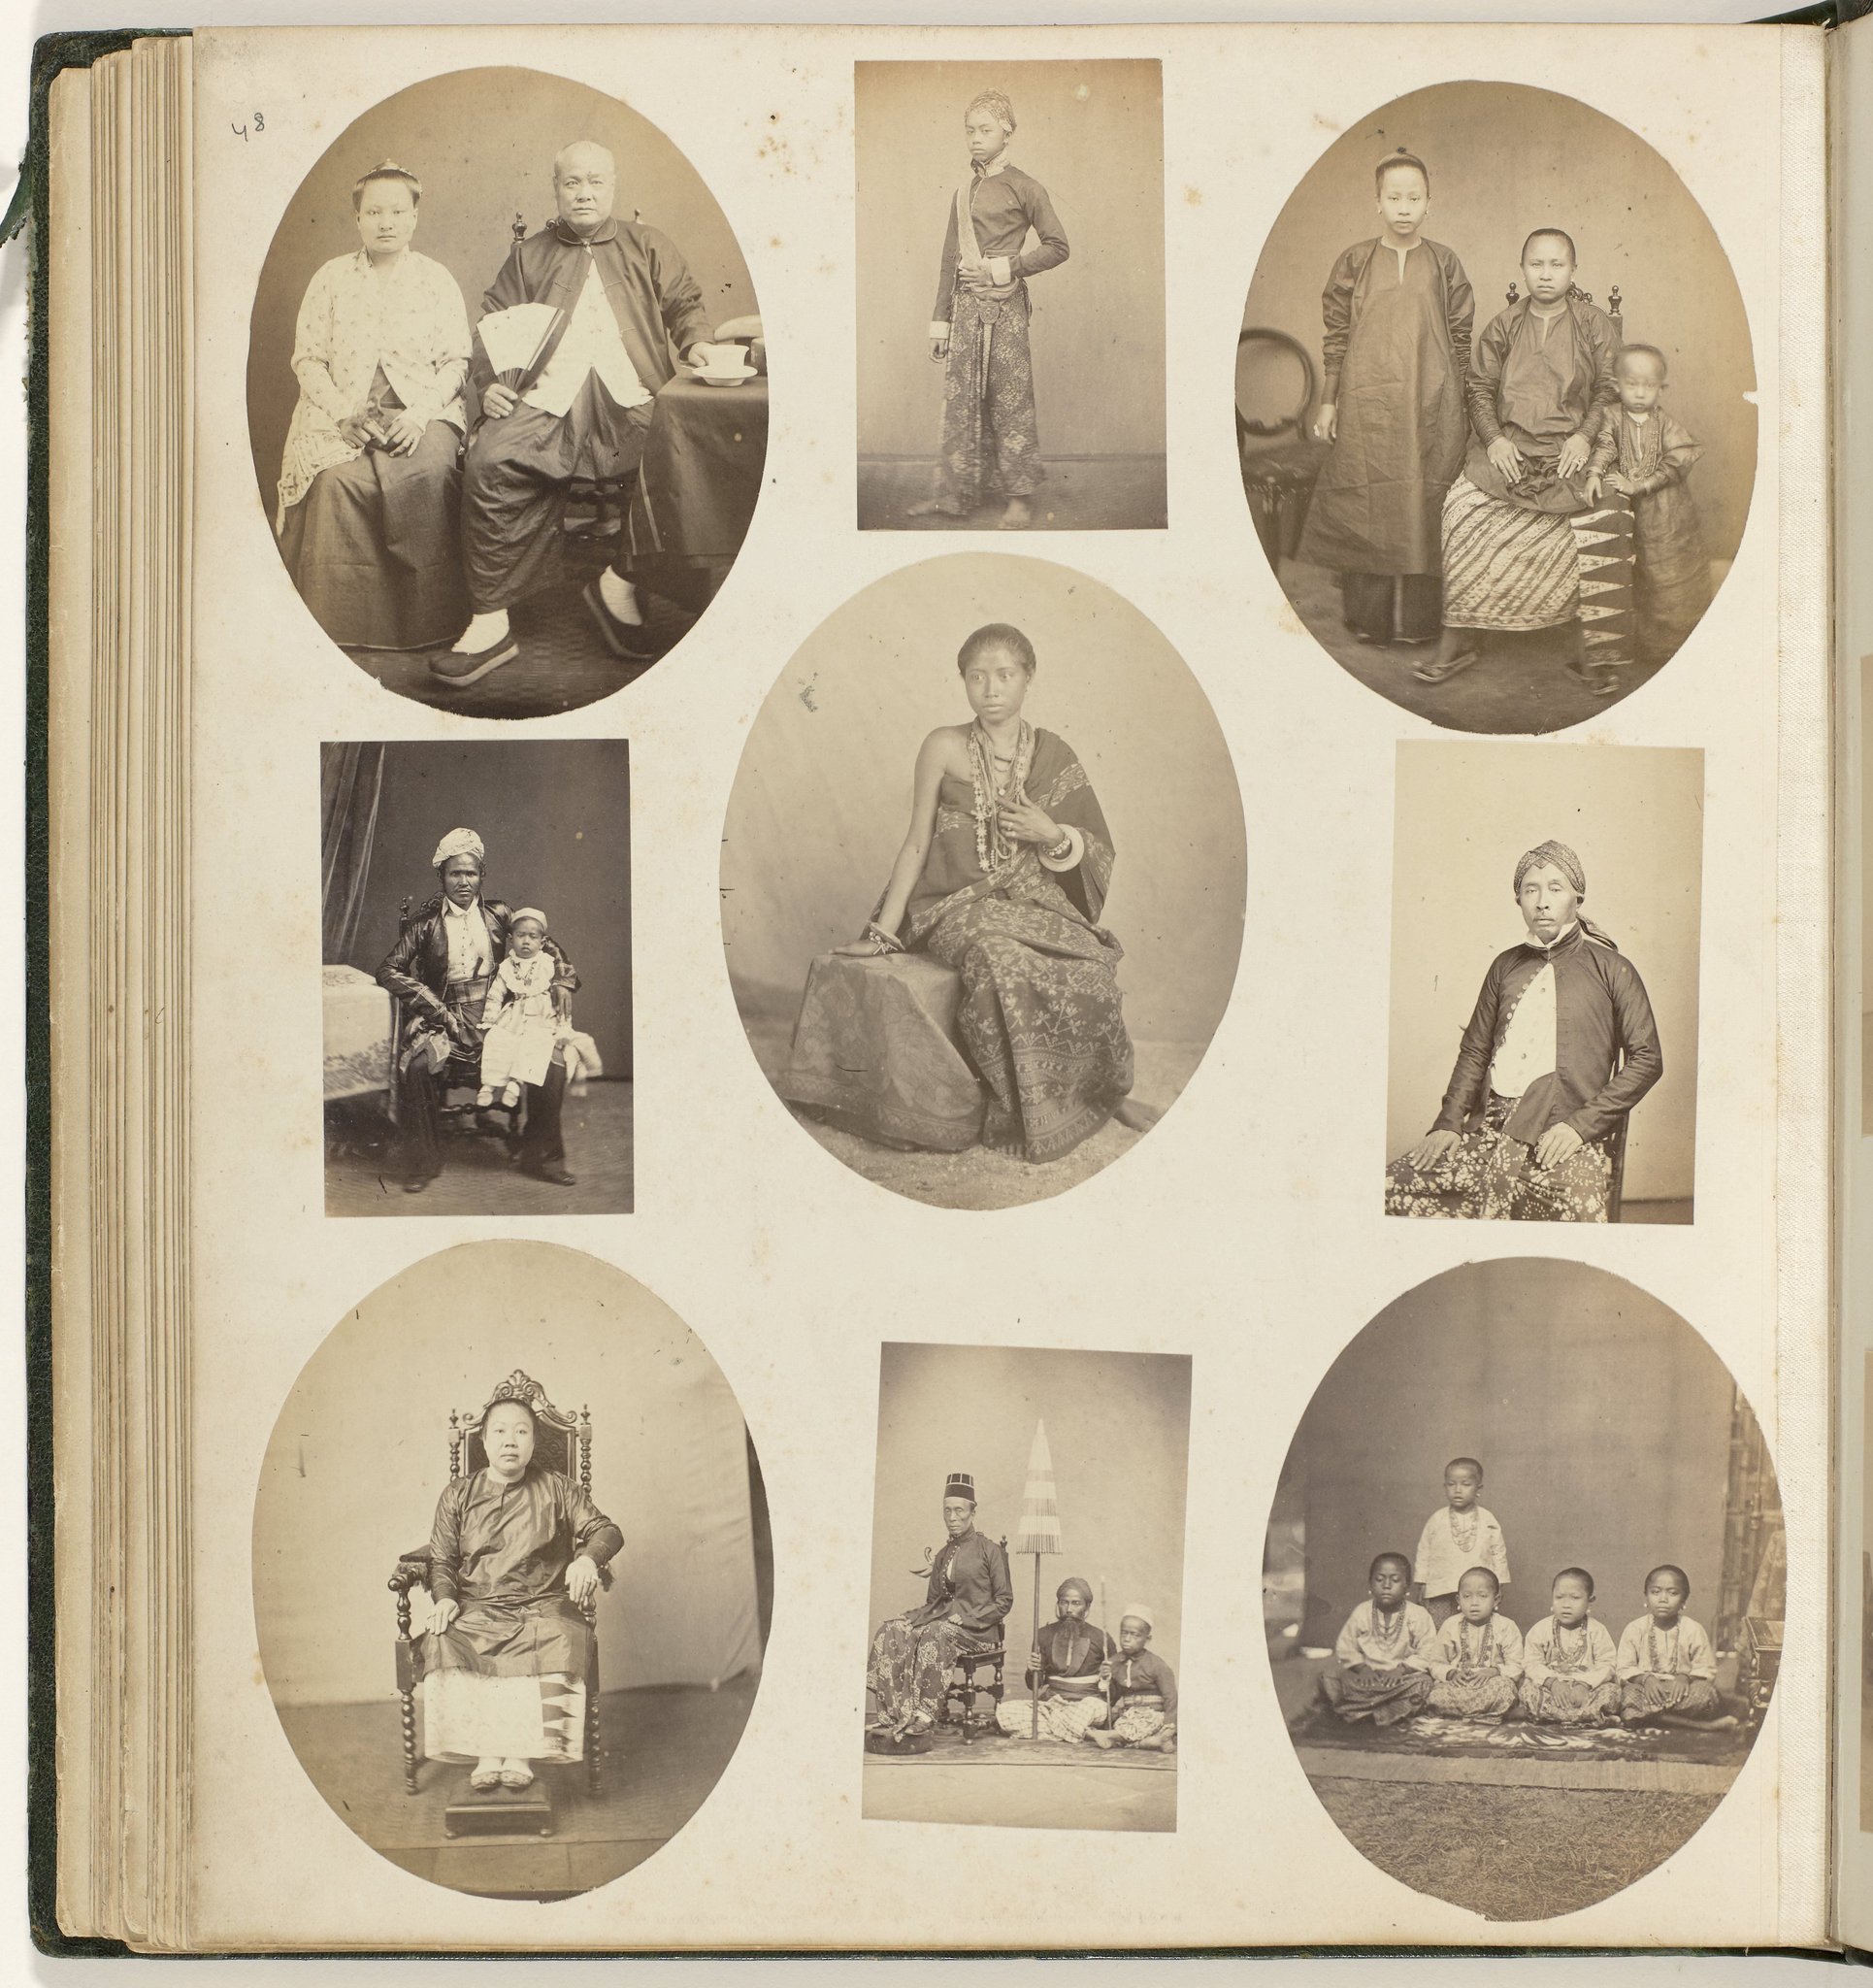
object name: photograph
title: Indische hoogwaardigheidsbekleders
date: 1863-1866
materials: cardboard, photographic support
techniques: albumen print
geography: batavia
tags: historical persons not known by name - bb - woman, ruler, sovereign, historical persons not known by name, batavia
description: Albumblad met negen studioportretten van Indische hoogwaardigheidsbekleders met hun kinderen en echtgenotes en enkele Chinezen. Bevat onder andere een portret van de regent van Tegal. Onderdeel van het tweede groene fotoalbum met foto's van Java, uit het bezit van apotheker Specht-Grijp, die in 1865 vanuit Batavia naar Nederland terugkeerde.